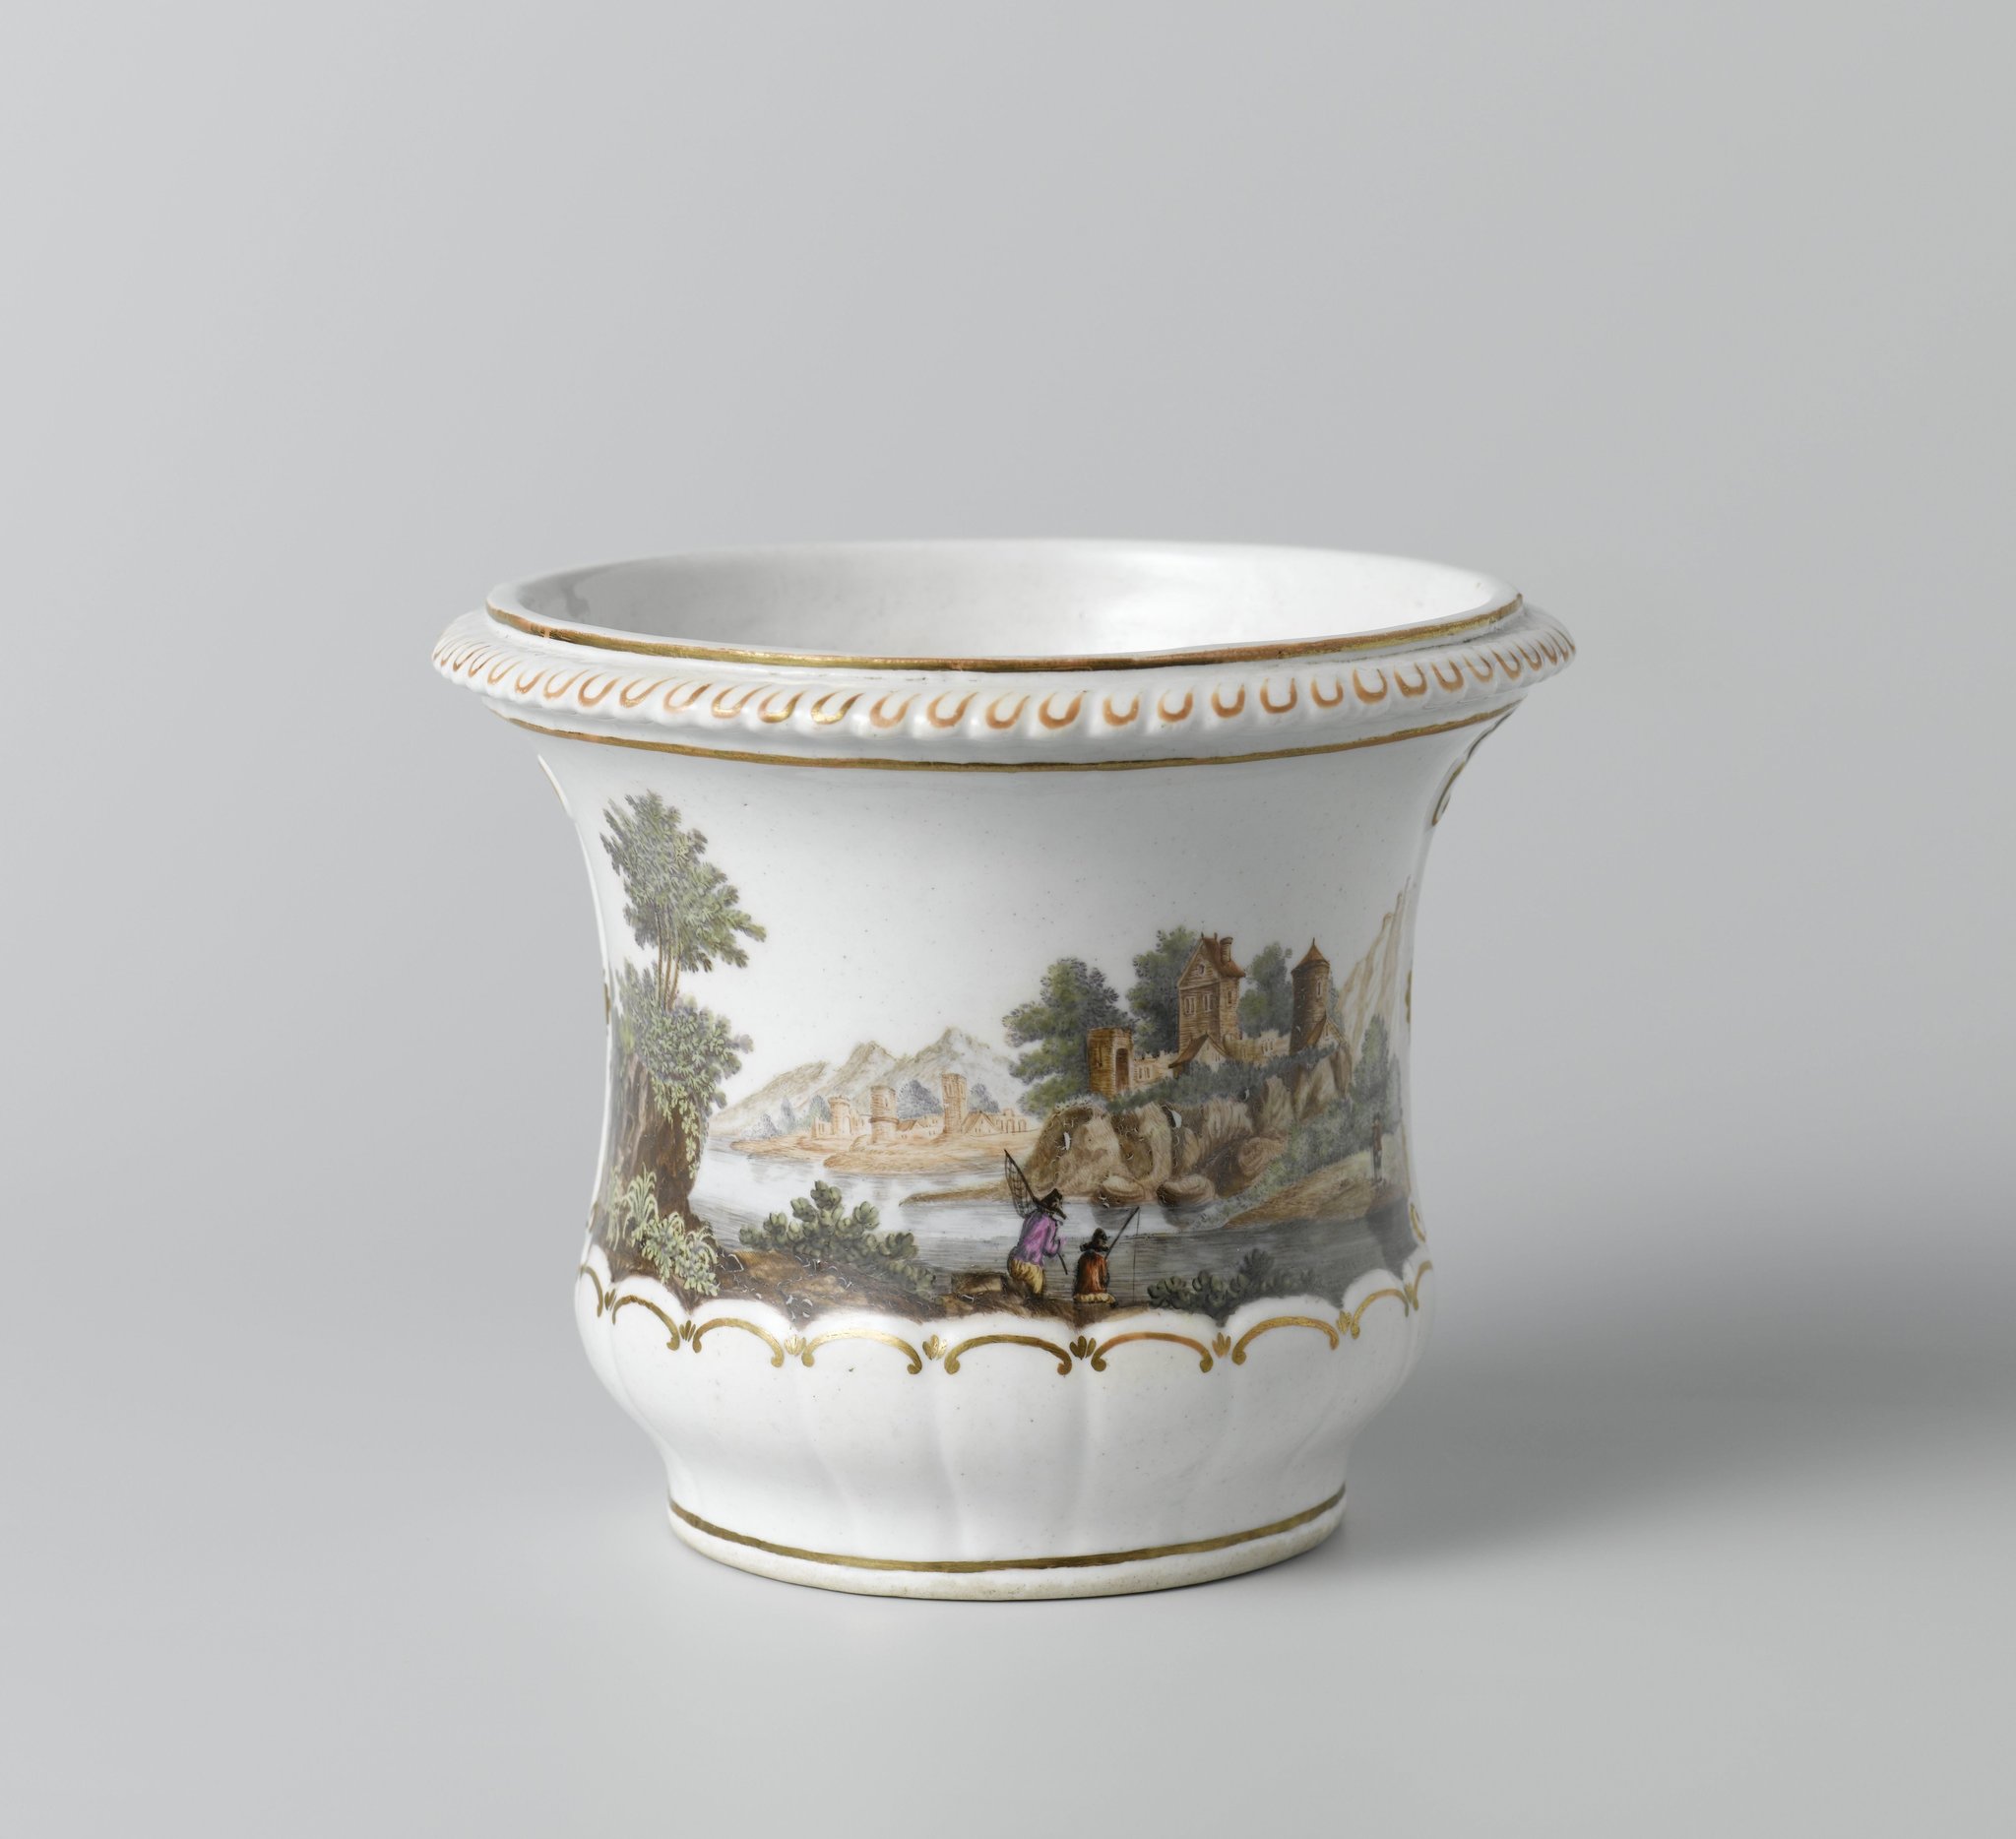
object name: cachepot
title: Two flowerpot containers (cache-pots) and stands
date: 1778-1782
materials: porcelain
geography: loosdrecht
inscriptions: mark: ‘L12’, factory mark: ‘M:OL’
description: Manufactuur Oud-Loosdrecht Loosdrecht, c. 1778–1782 hard-paste porcelain